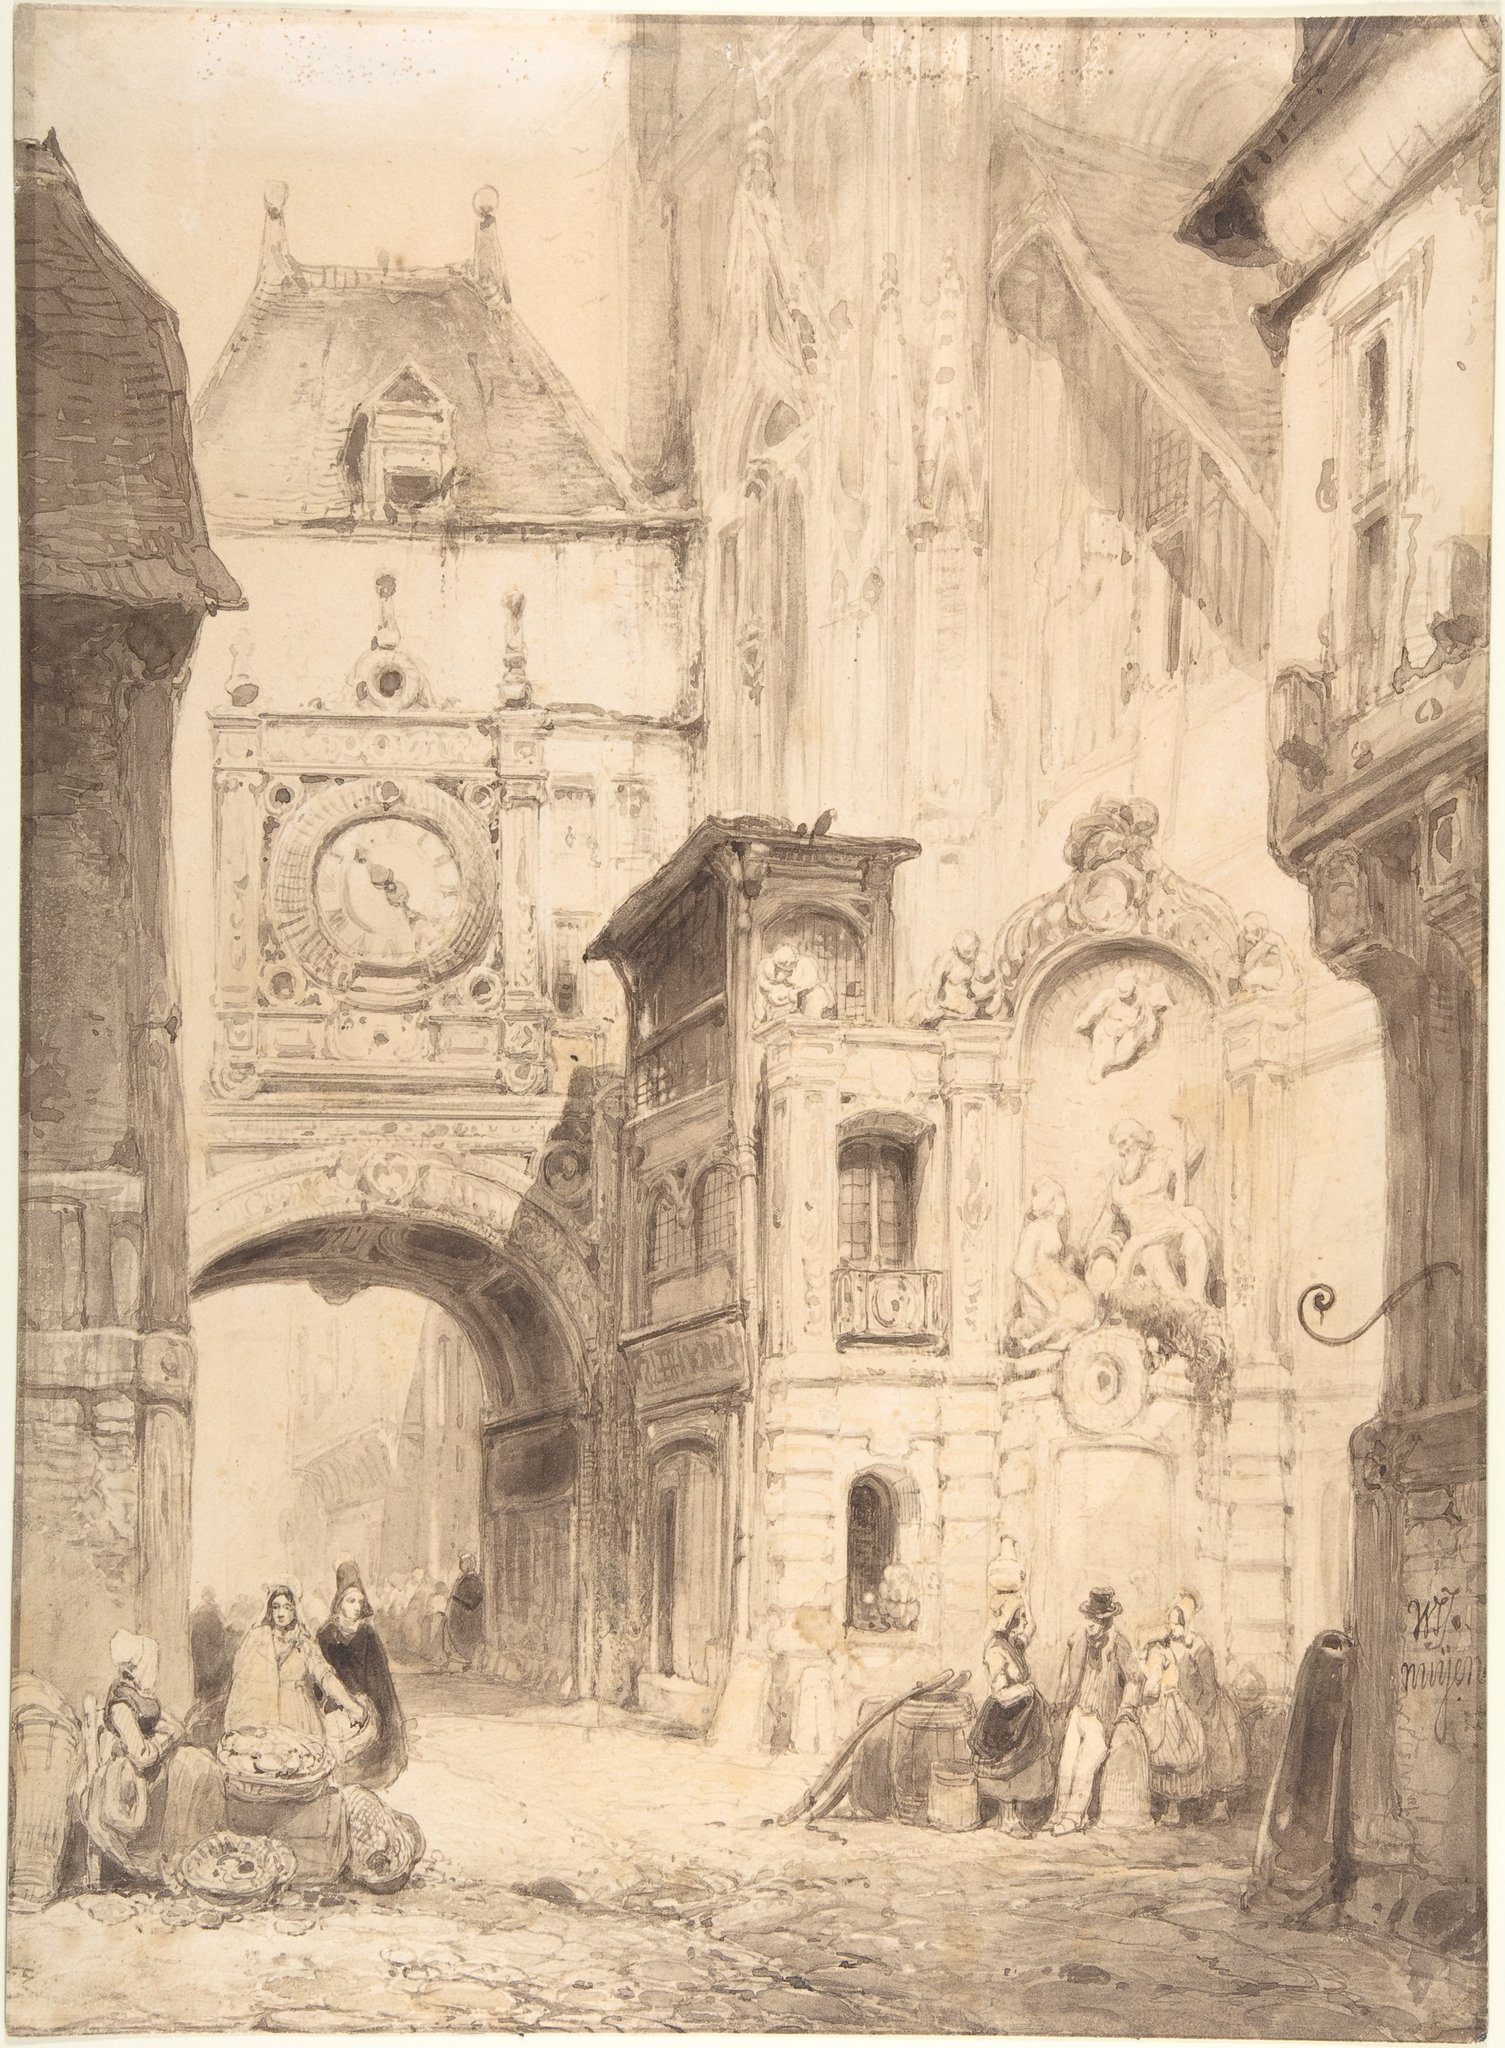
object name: drawing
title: Rue du Gros Horloge, Rouen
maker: wijnand jan joseph nuijen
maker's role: artist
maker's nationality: dutch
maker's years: 1813-1839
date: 1801-1833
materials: chalk, pencil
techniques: wash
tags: buildings,cathedrals,towns,clocks